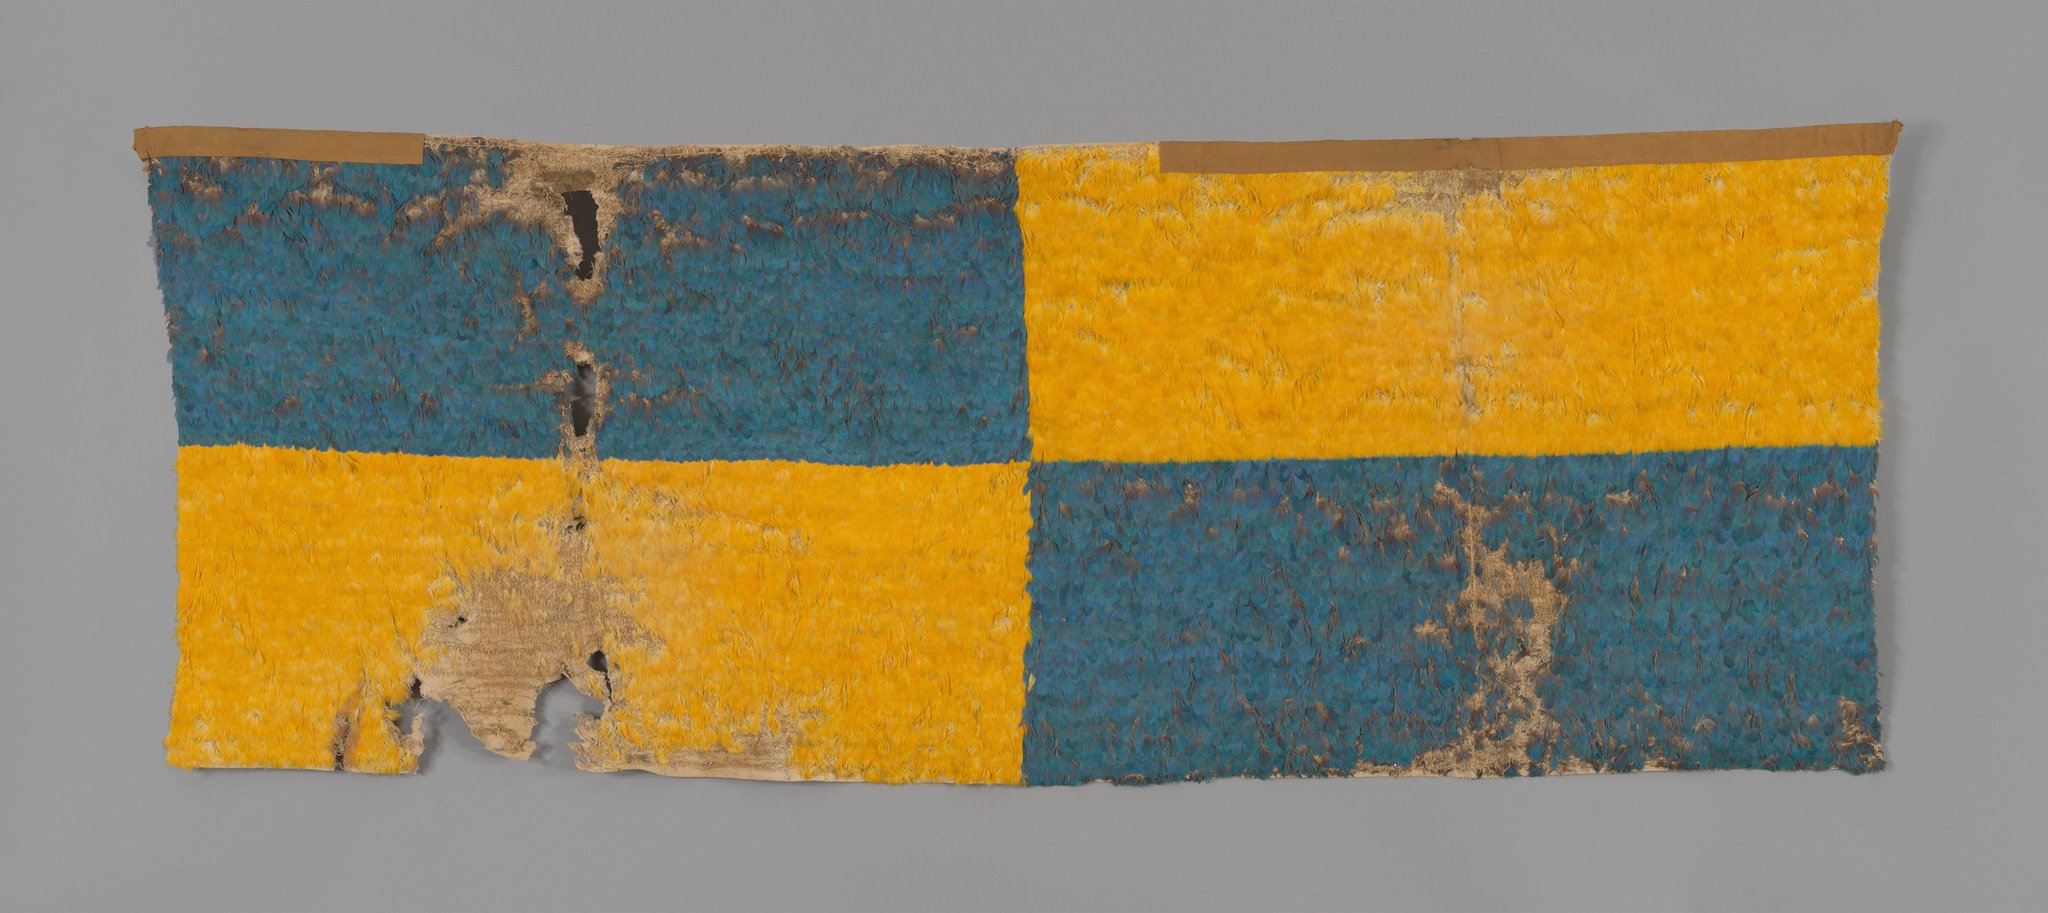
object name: panel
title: Feathered Panel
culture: wari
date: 600-900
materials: animal fiber, cotton, feather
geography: peru